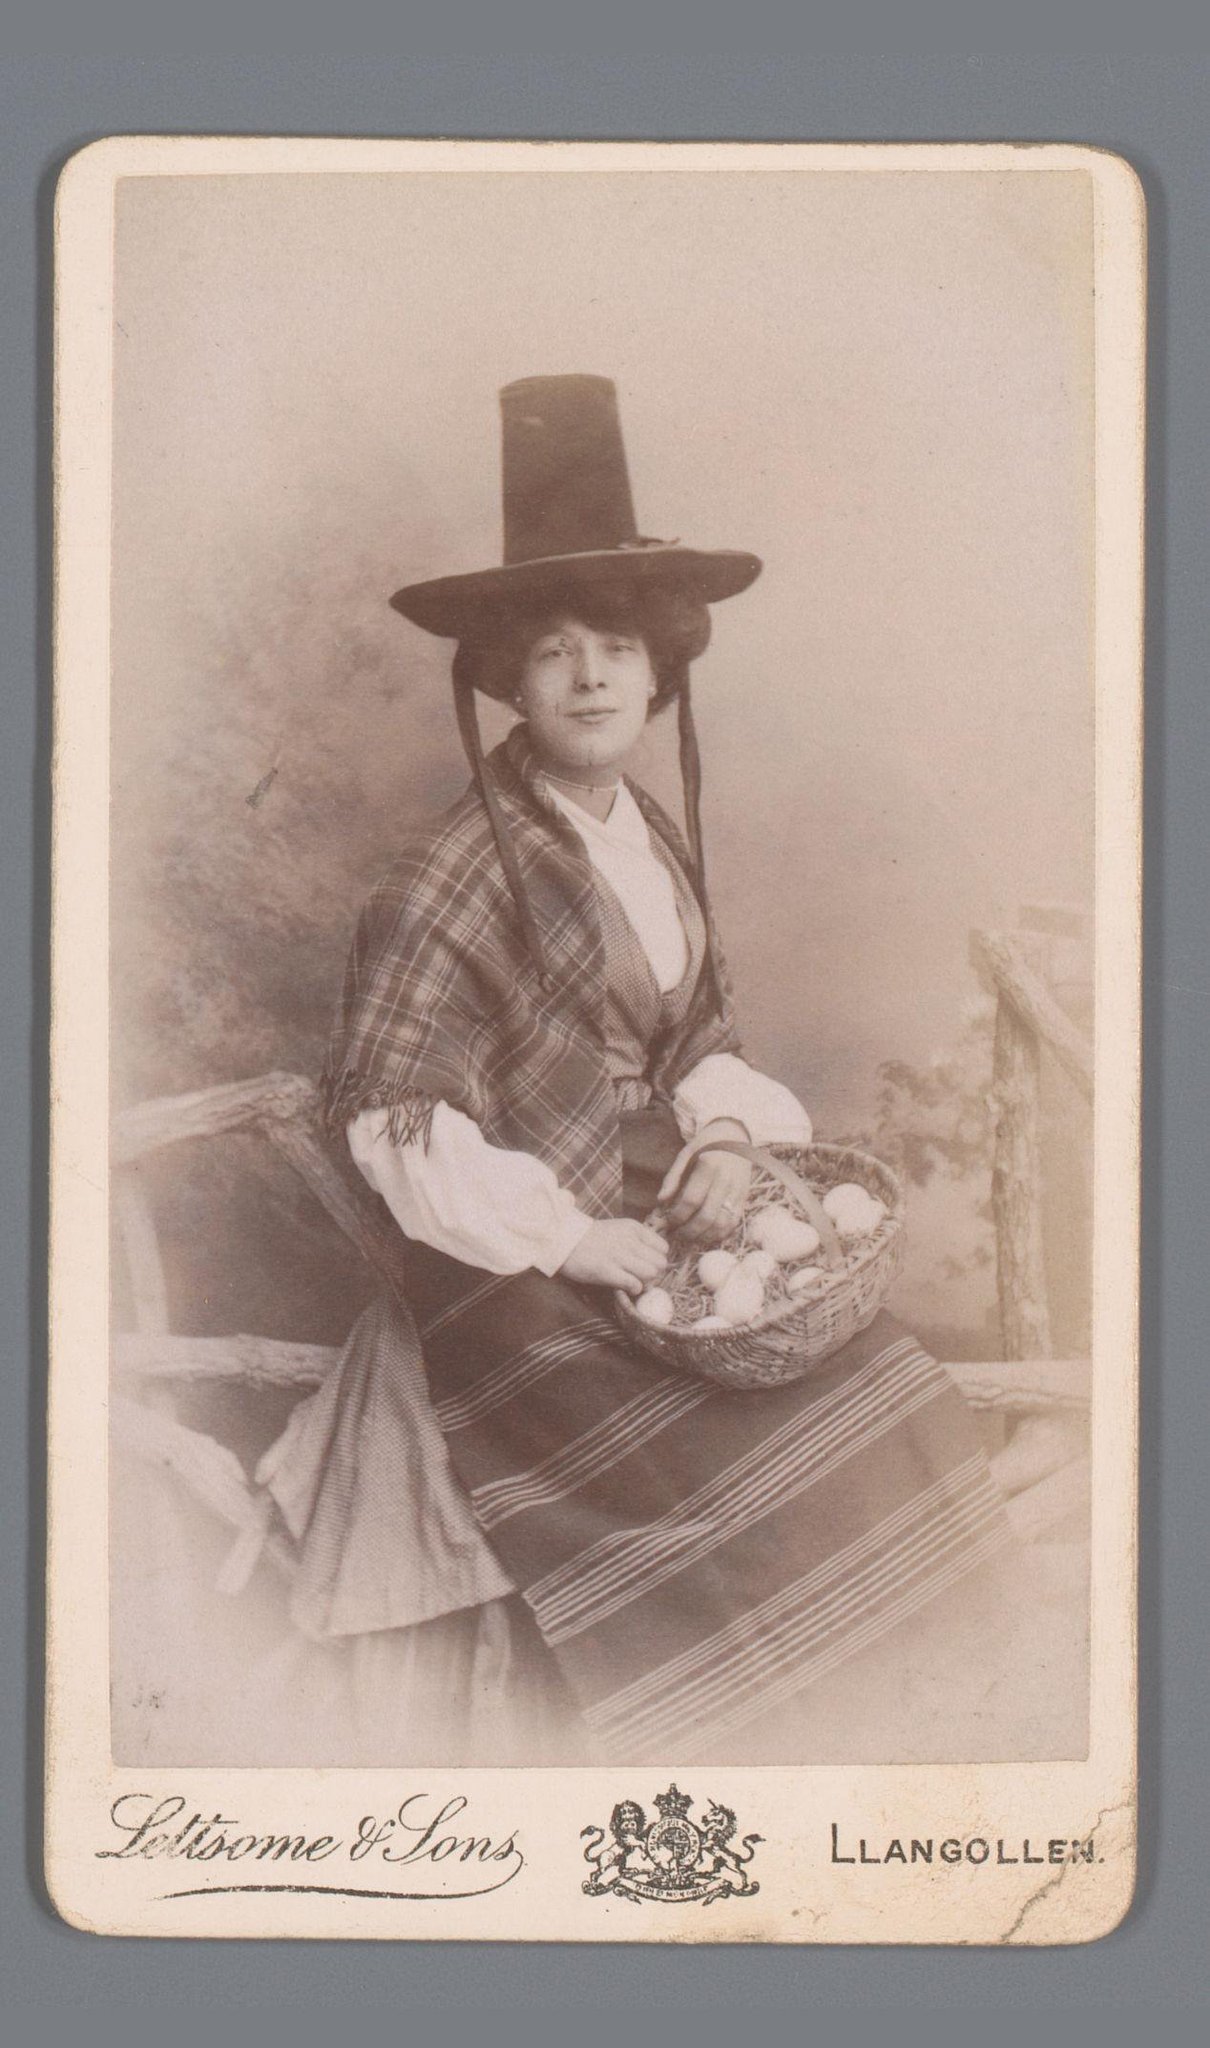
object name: photograph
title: Portret van een onbekende vrouw met hoed en rieten mand met eieren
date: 1901-1914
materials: cardboard, paper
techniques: albumen print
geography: llangollen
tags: adult woman, anonymous historical person portrayed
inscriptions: inscription: ‘By Royal Warrent to her late majesty Queen Victoria’, inscription: ‘Enlargements up to/ Life Size in Oils,/ Water Color, Black & White/ Crayons./ ALL NEGATIVES KEPT./ ADDITIONAL COPIES CAN/ ALWAYS BE OBTAINED.’